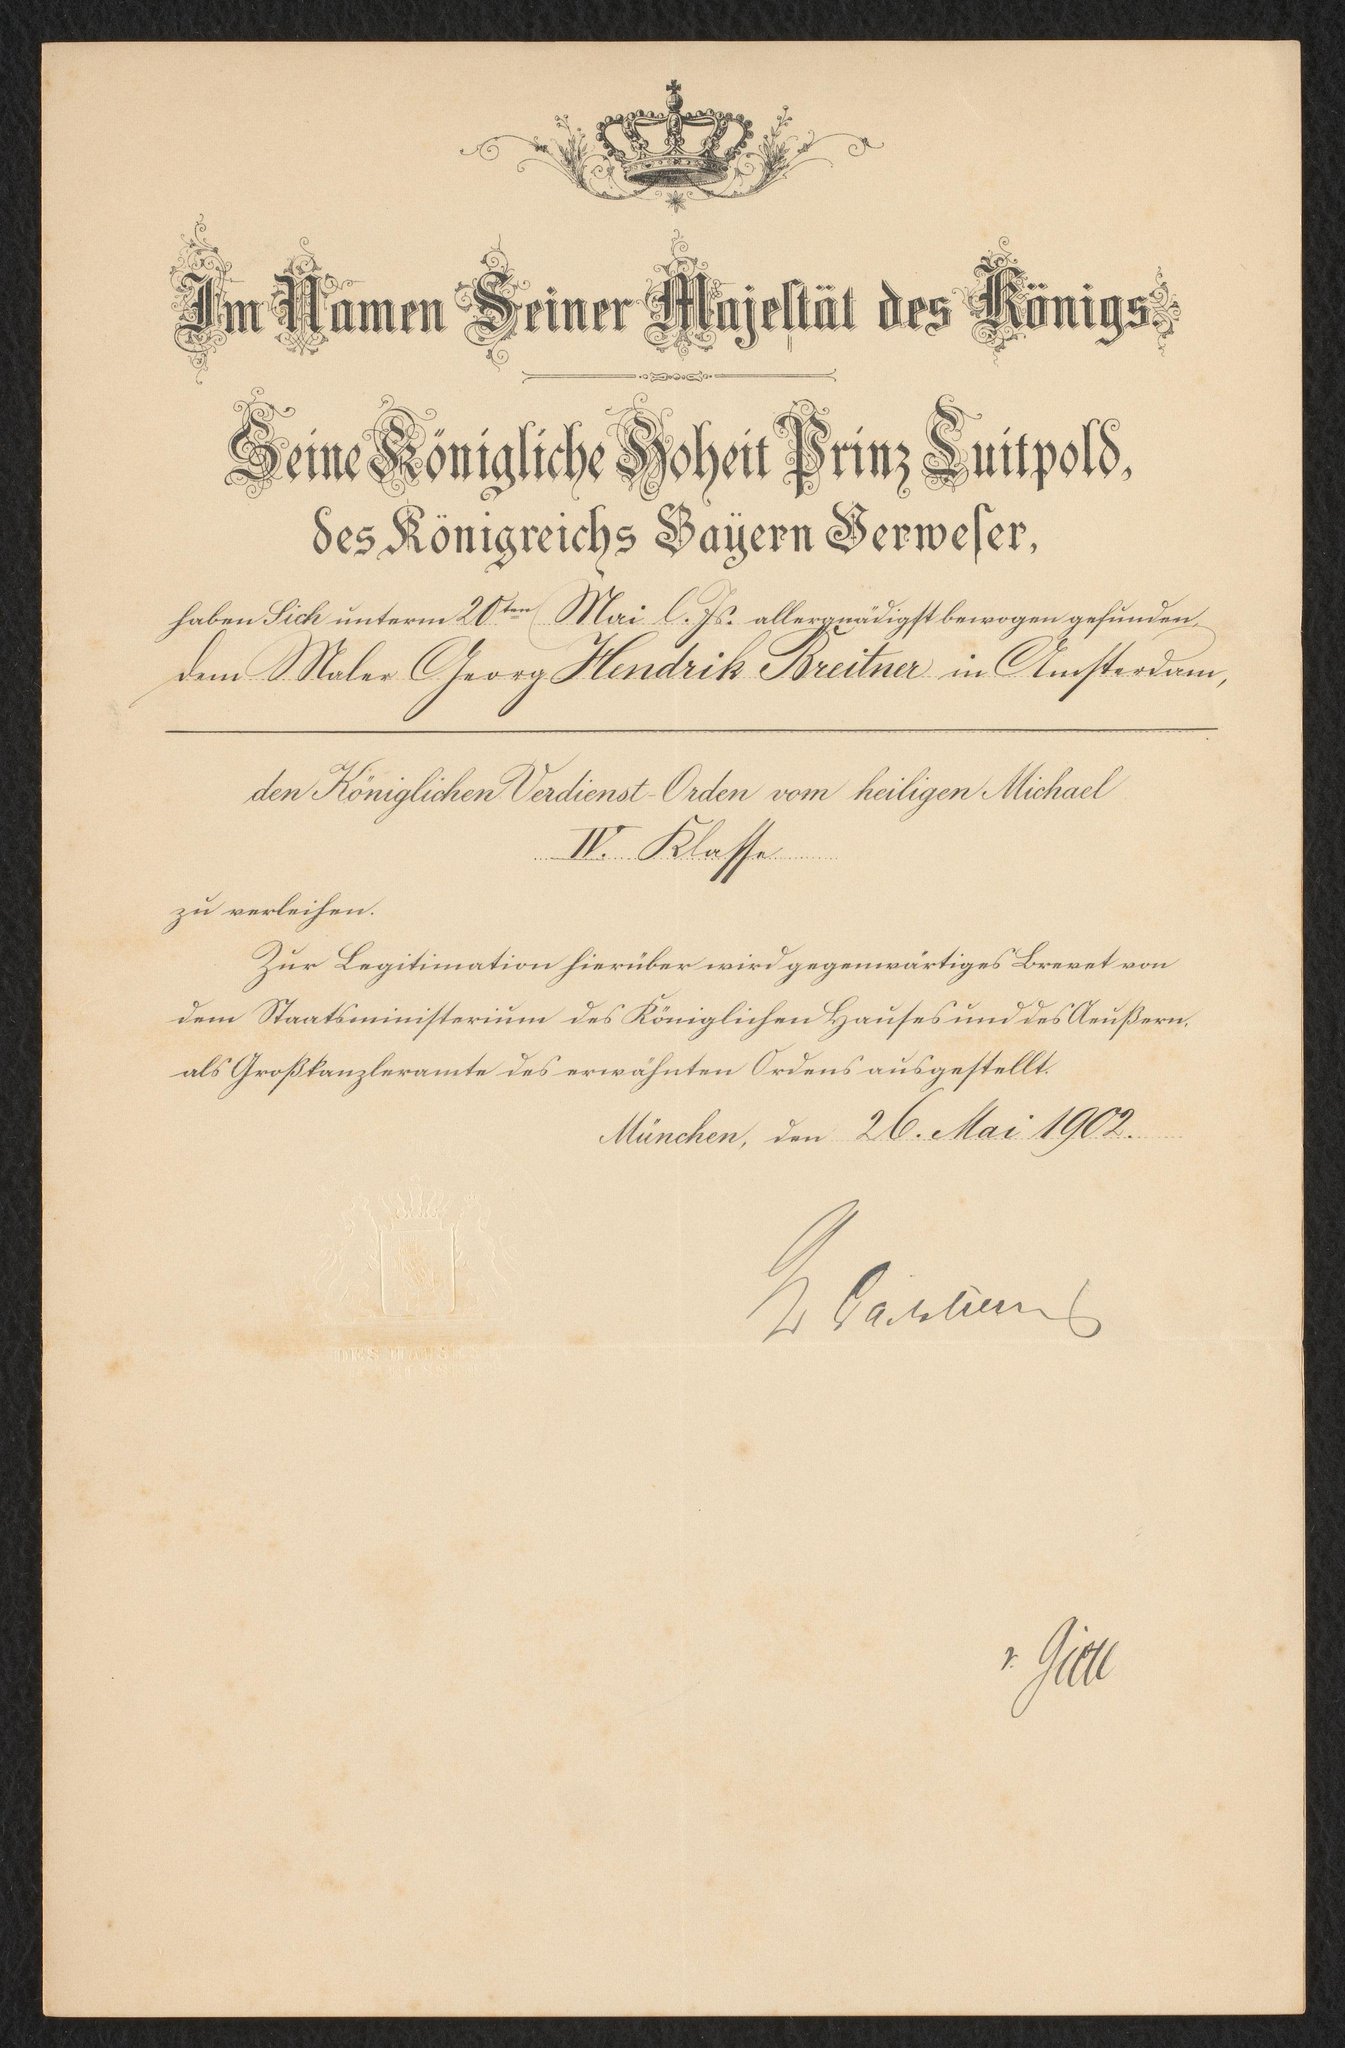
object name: letter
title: Brief gericht aan George Hendrik Breitner betreffende de benoeming van Breitner tot ridder derde klasse in de Orde van St. Michaël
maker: Anonymous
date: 1906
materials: ink, paper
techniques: blind stamped, letterpress printing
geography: munich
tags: rotterdam, amsterdam, painter, print maker, draughtsman, george hendrik breitner, distribution of awards ~ art contest